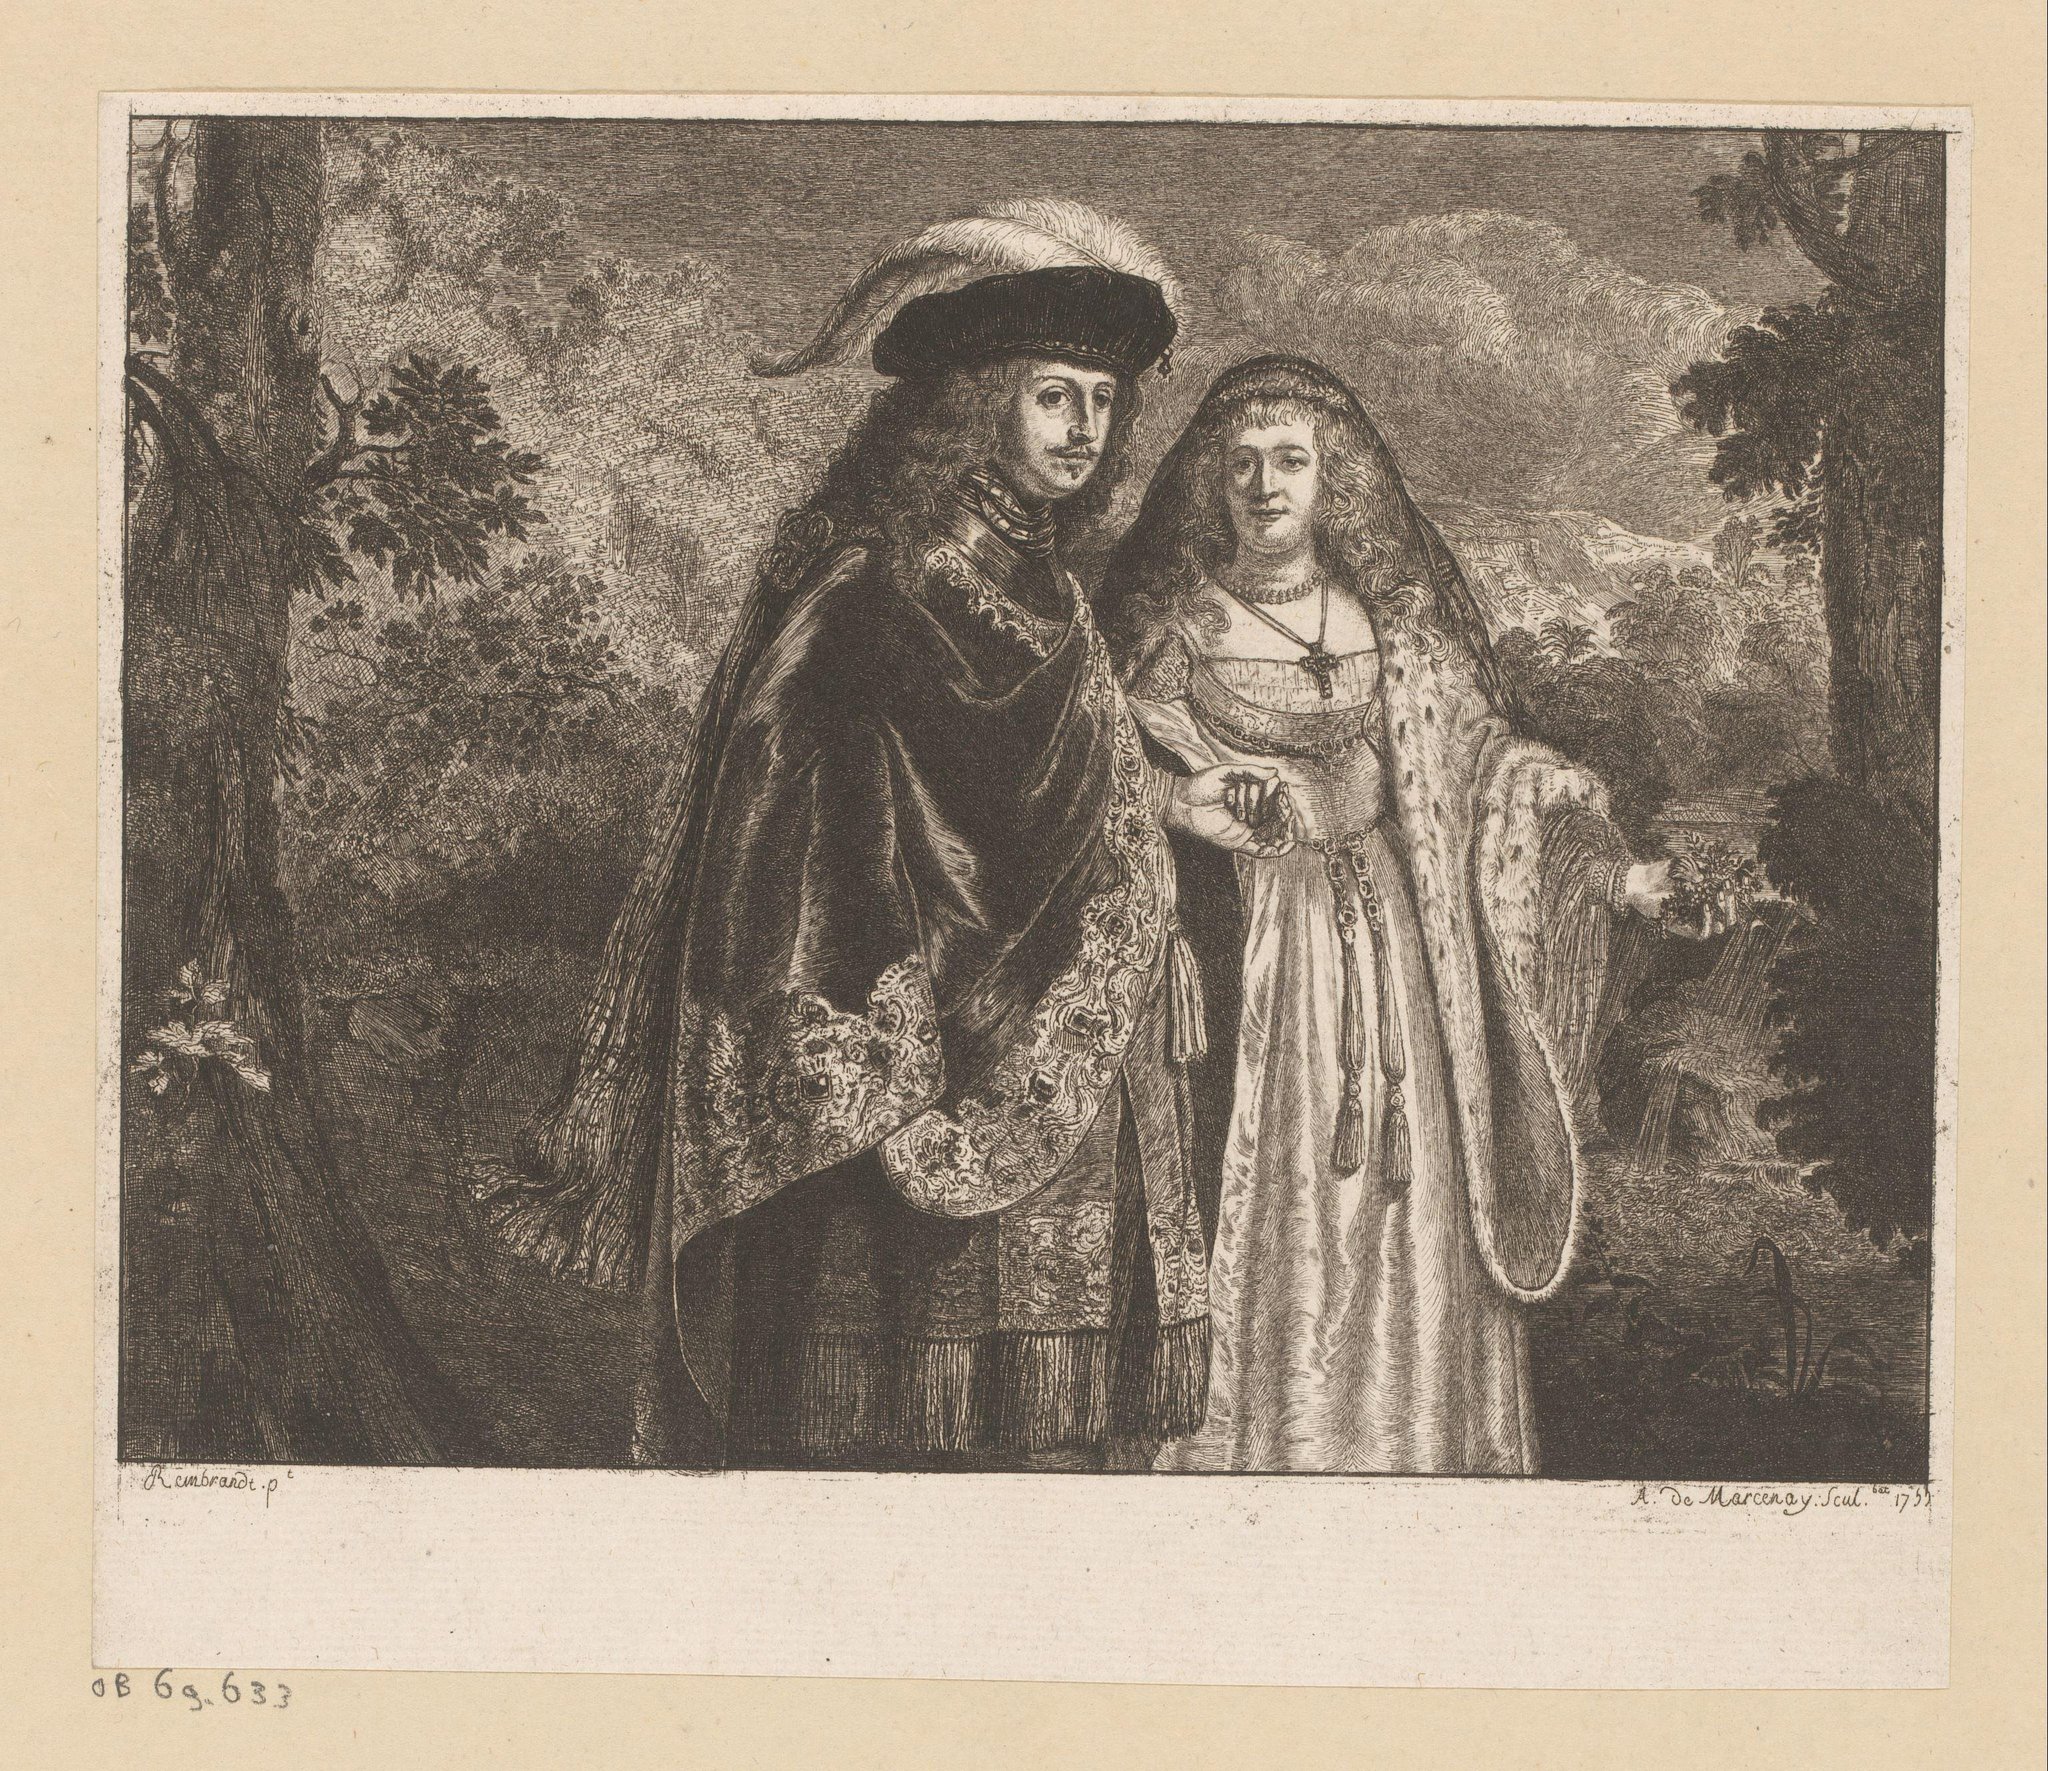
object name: print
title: Portret van een rijk gekleed echtpaar in een landschap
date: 1755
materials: paper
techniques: engraving, etching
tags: historical persons, marriage, married couple, 'matrimonium'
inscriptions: collector's mark: Lugt 2228